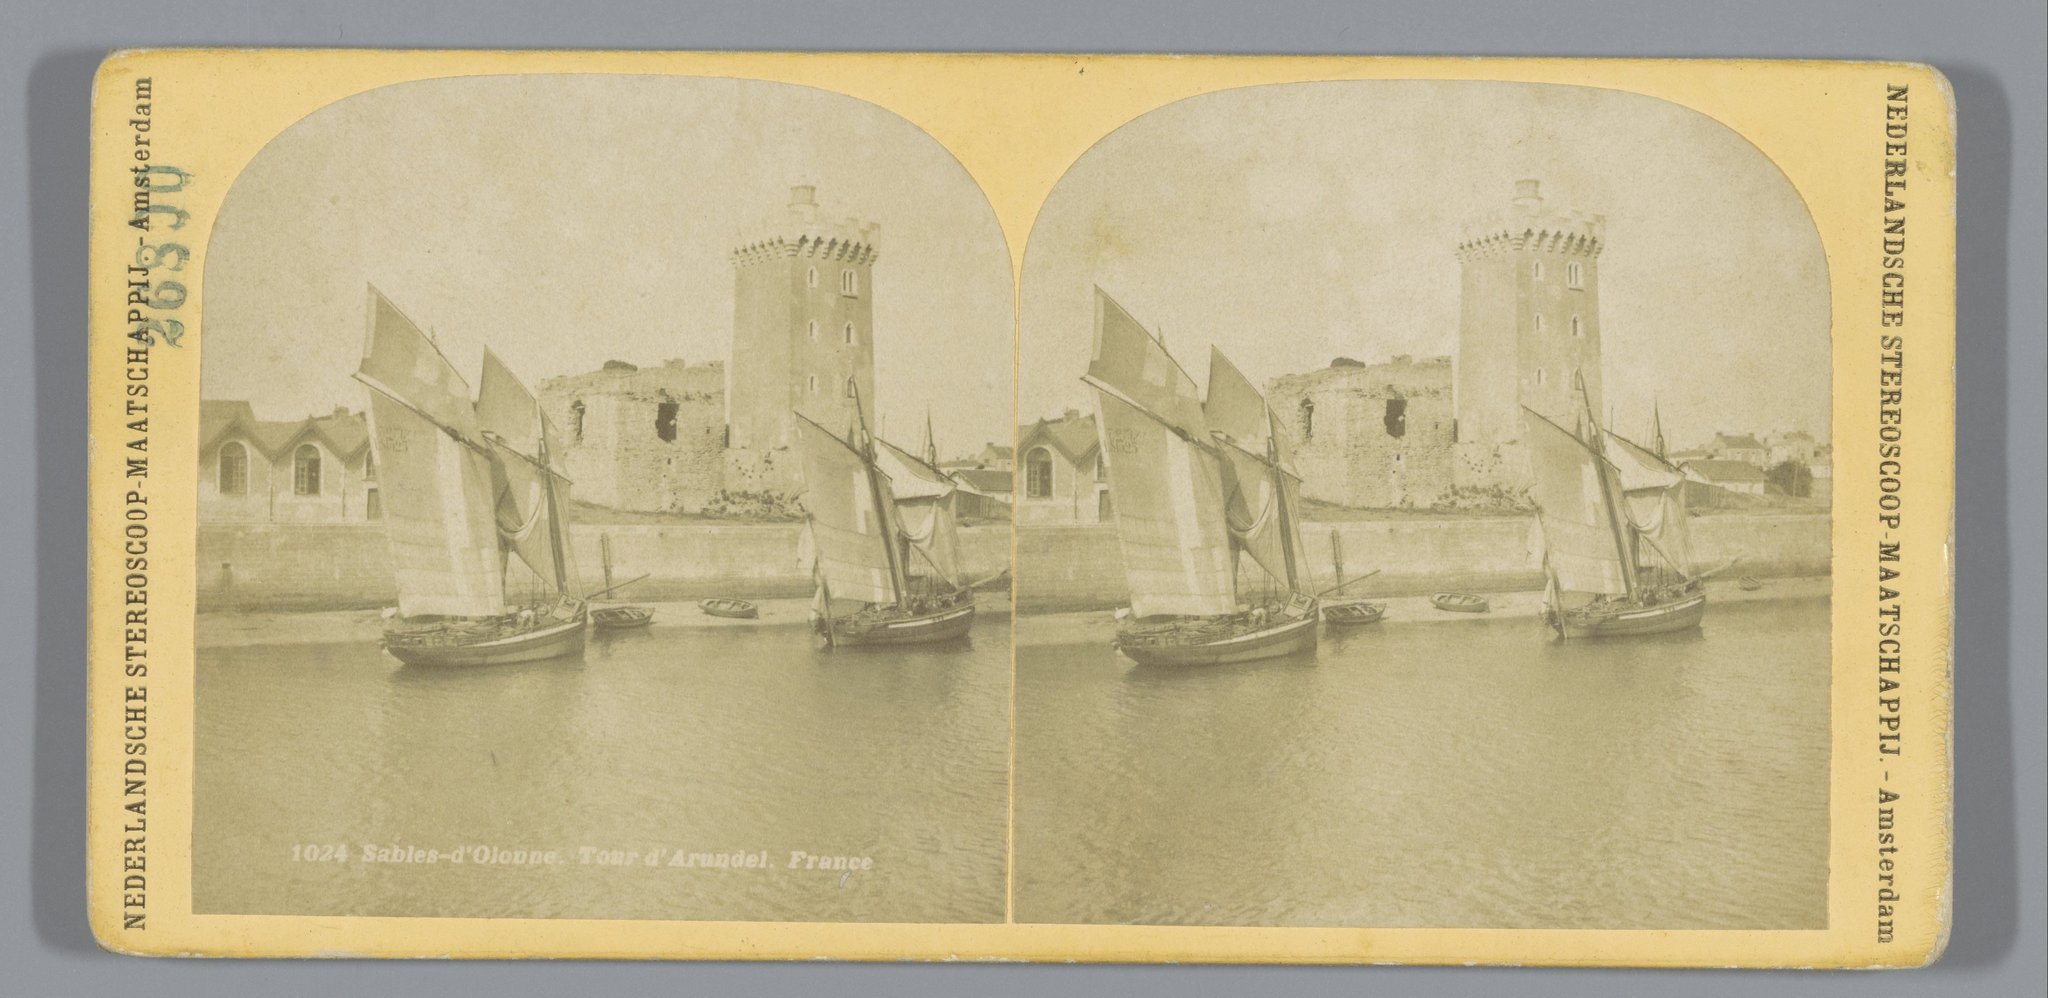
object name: stereograph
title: Zeilschepen voor de Tour d'Arundel te Les Sables-d'Olonne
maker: j.g. beers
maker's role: fotograaf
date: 1860-1880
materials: cardboard, photographic support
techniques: albumen print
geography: amsterdam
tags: lighthouse, lightship, sailing-ship, sailing-boat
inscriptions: number: ‘1024’, number: ‘26800’